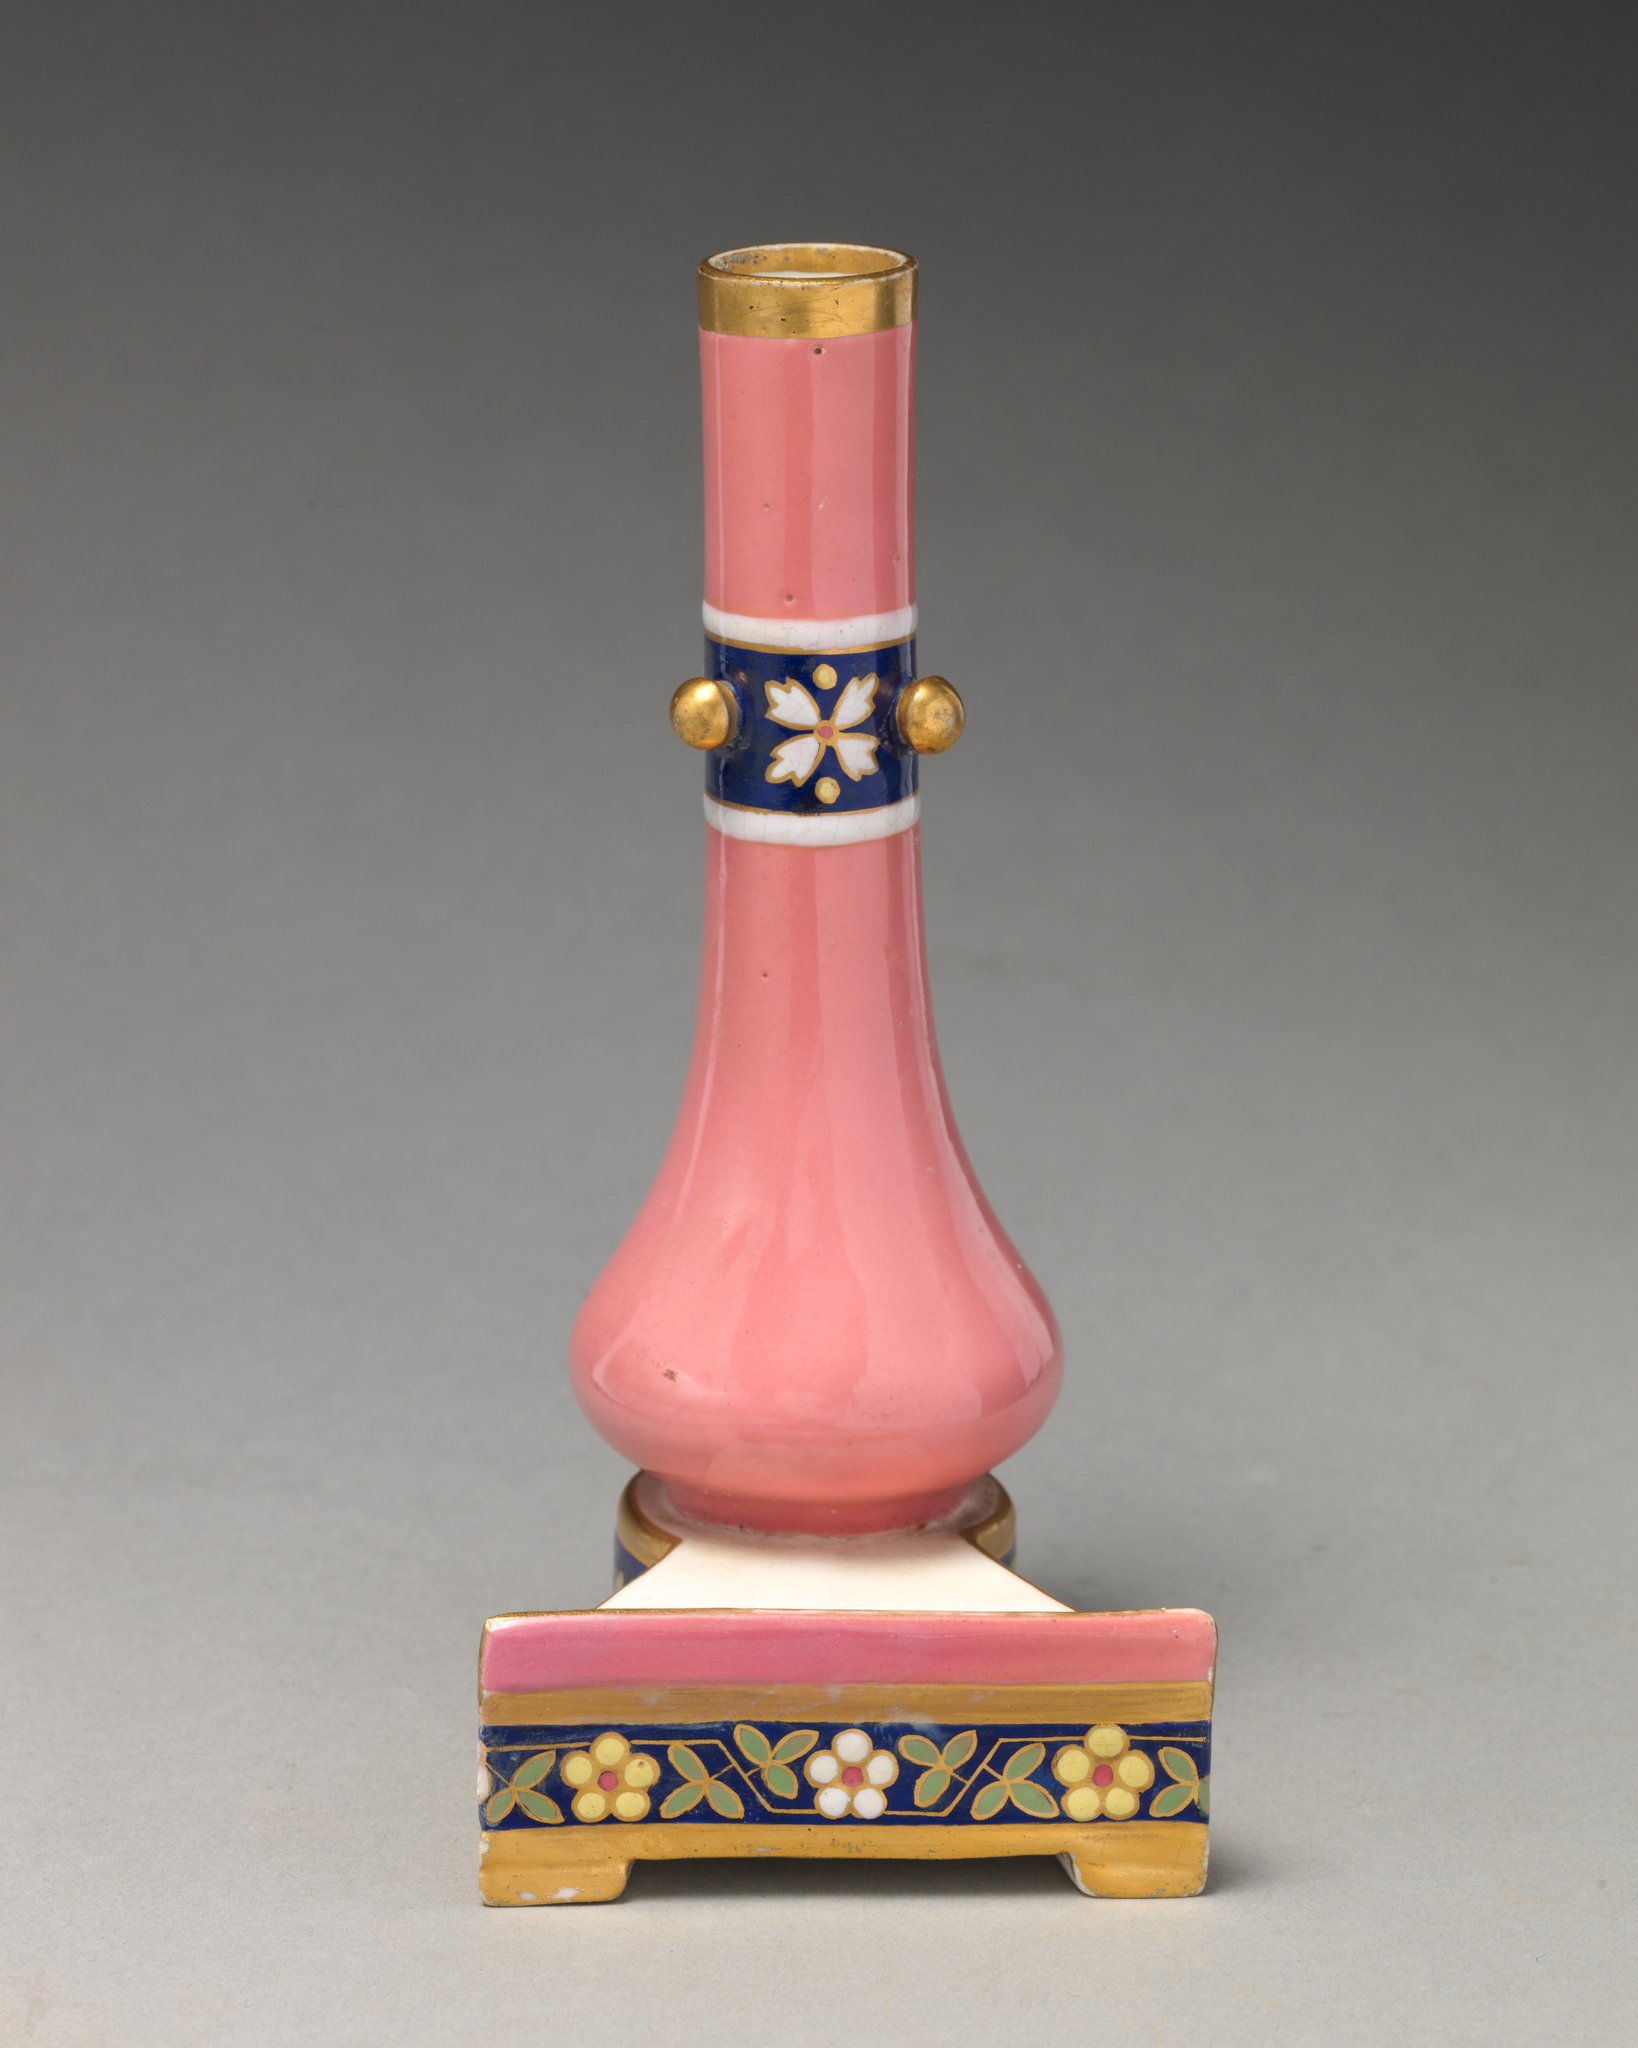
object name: vessel on triangular stand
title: Place card holder (one of a pair)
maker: minton(s)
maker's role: maker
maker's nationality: british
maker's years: 1793-2001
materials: bone china, enamel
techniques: gilding